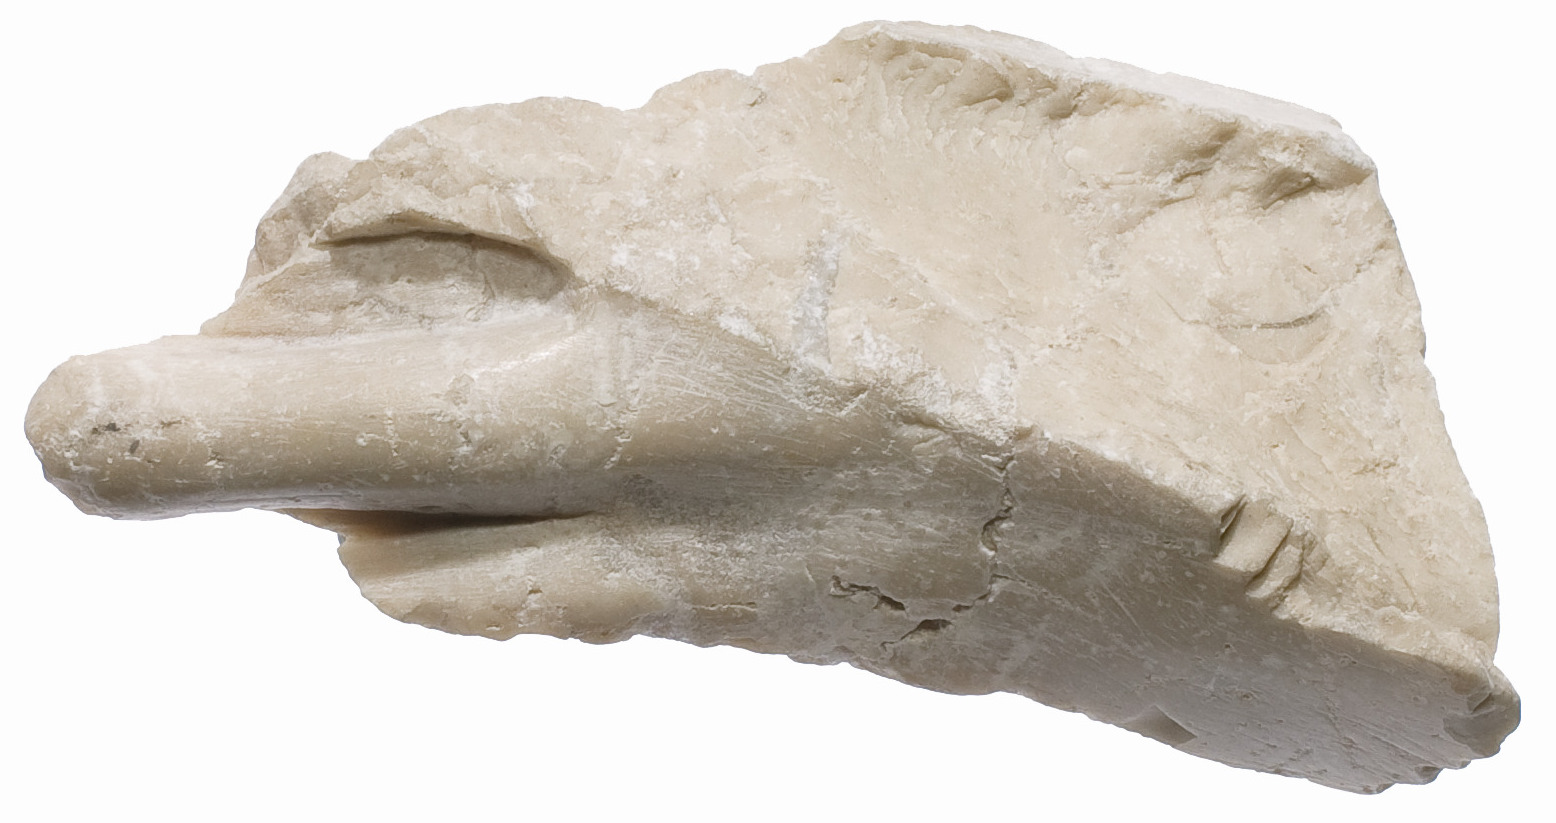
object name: foot fragment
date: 1353-1336 BCE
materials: limestone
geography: egypt